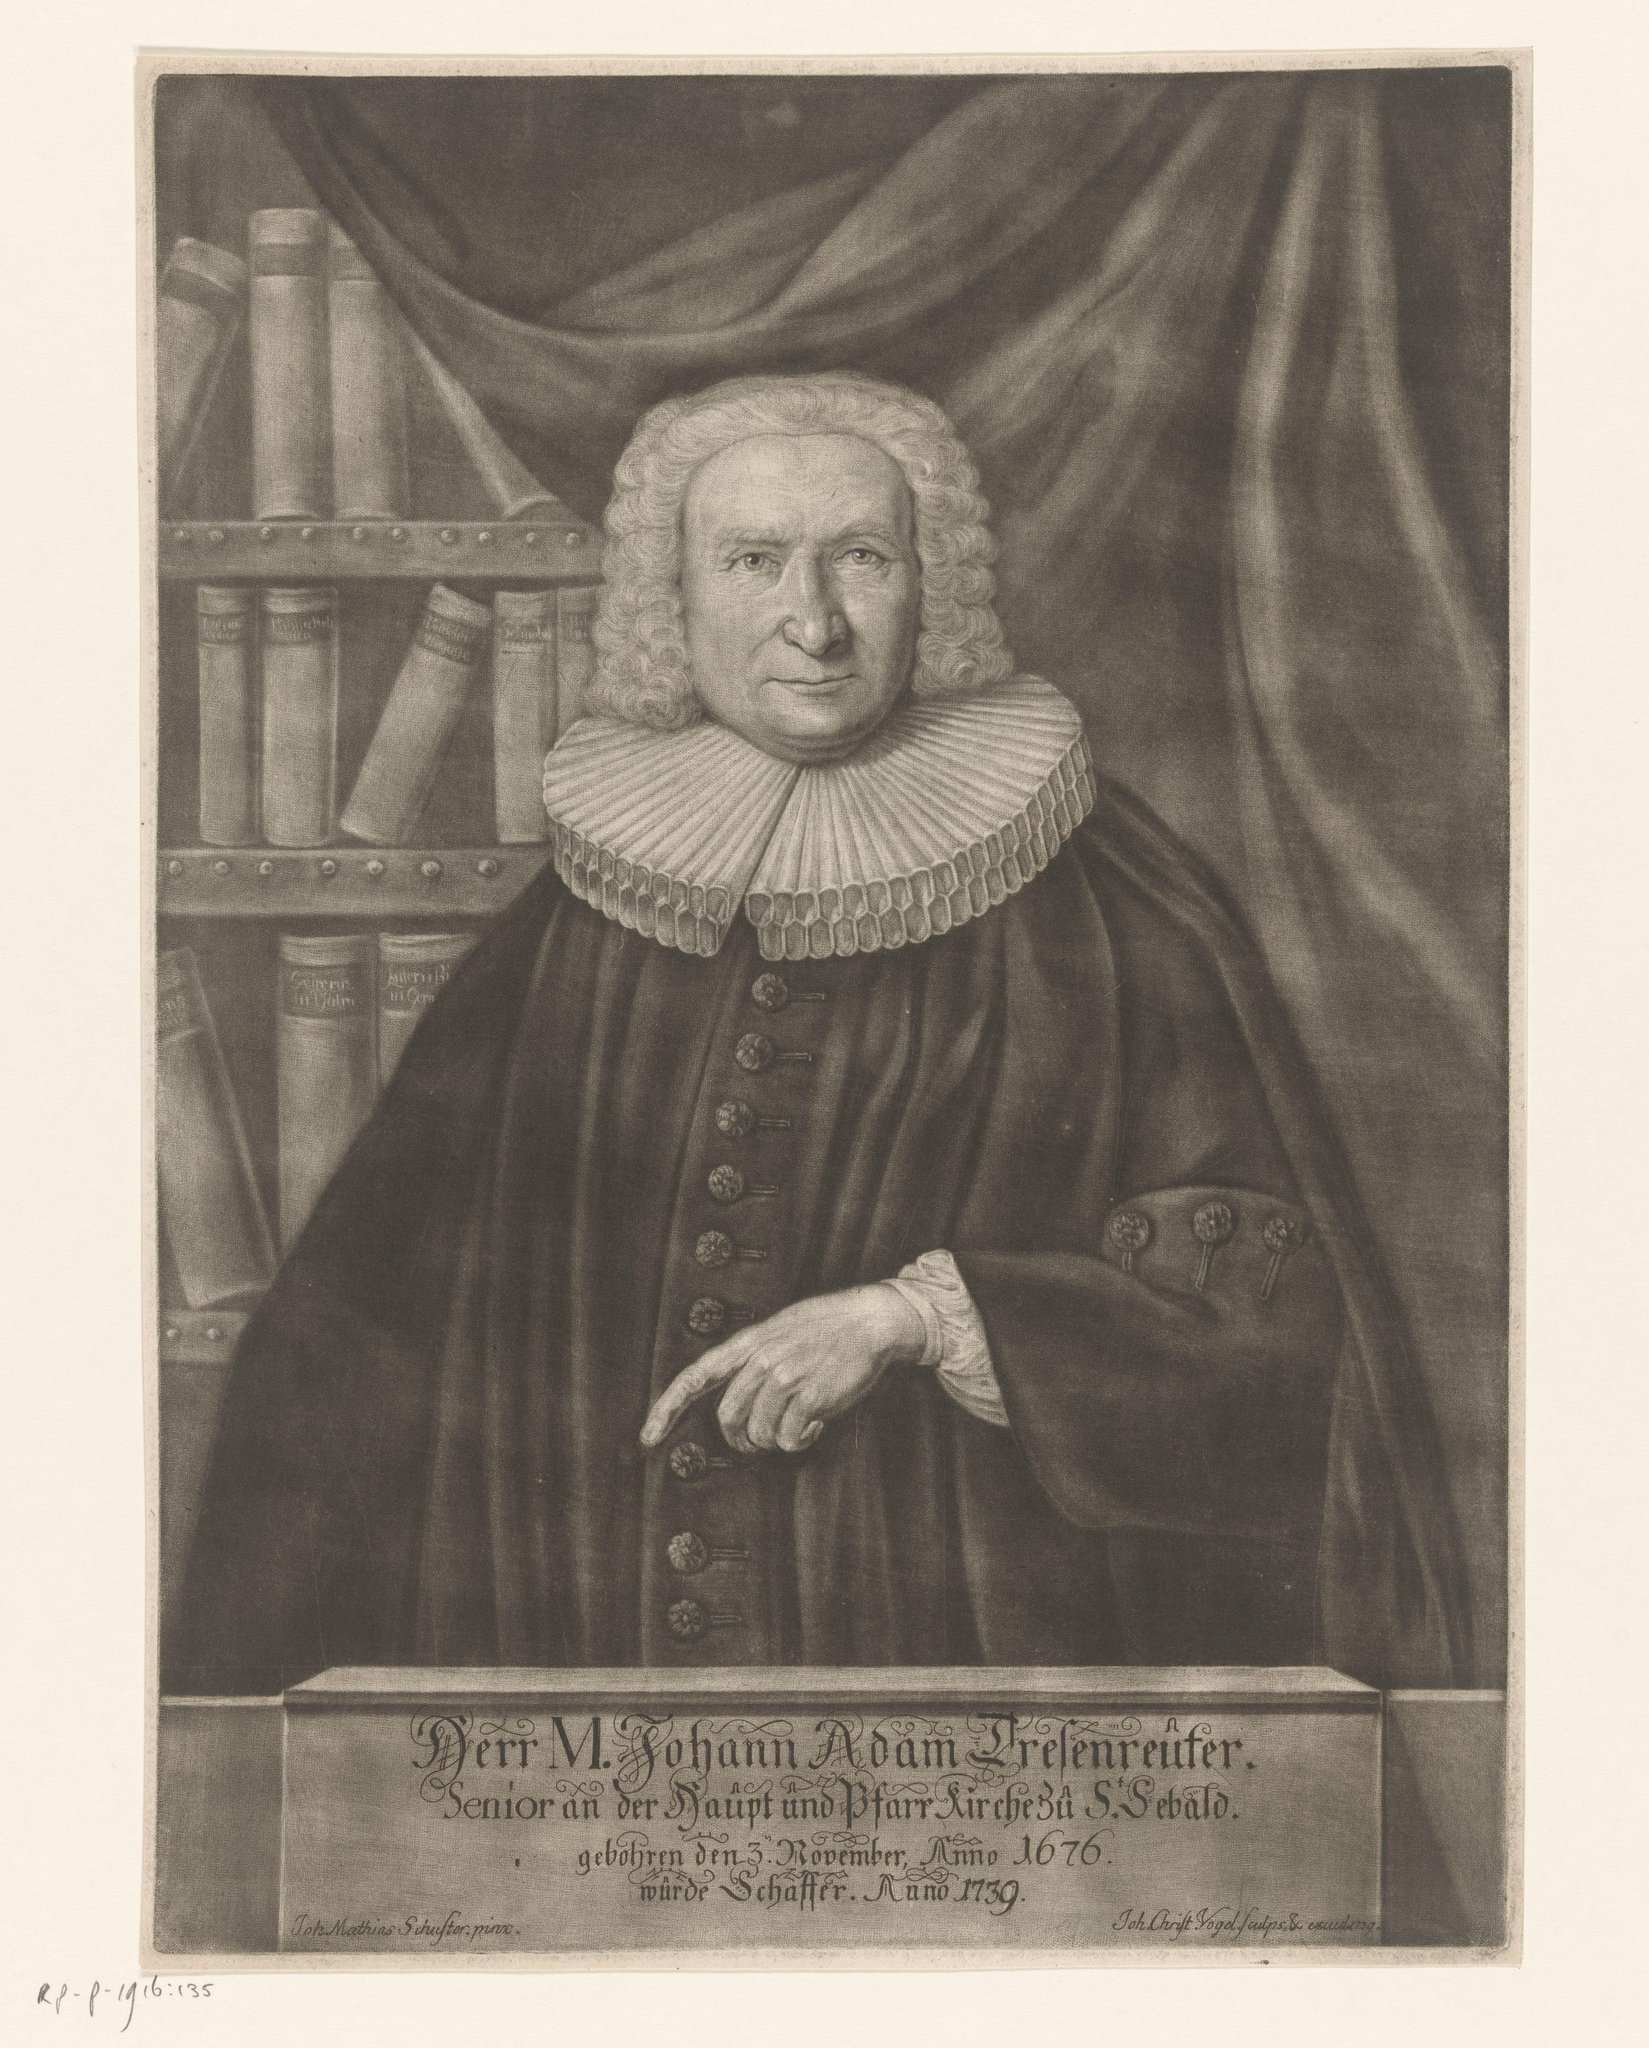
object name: print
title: Portret van Johann Adam Tresenreuter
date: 1739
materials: paper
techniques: mezzotint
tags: historical persons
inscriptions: collector's mark: Lugt 2228